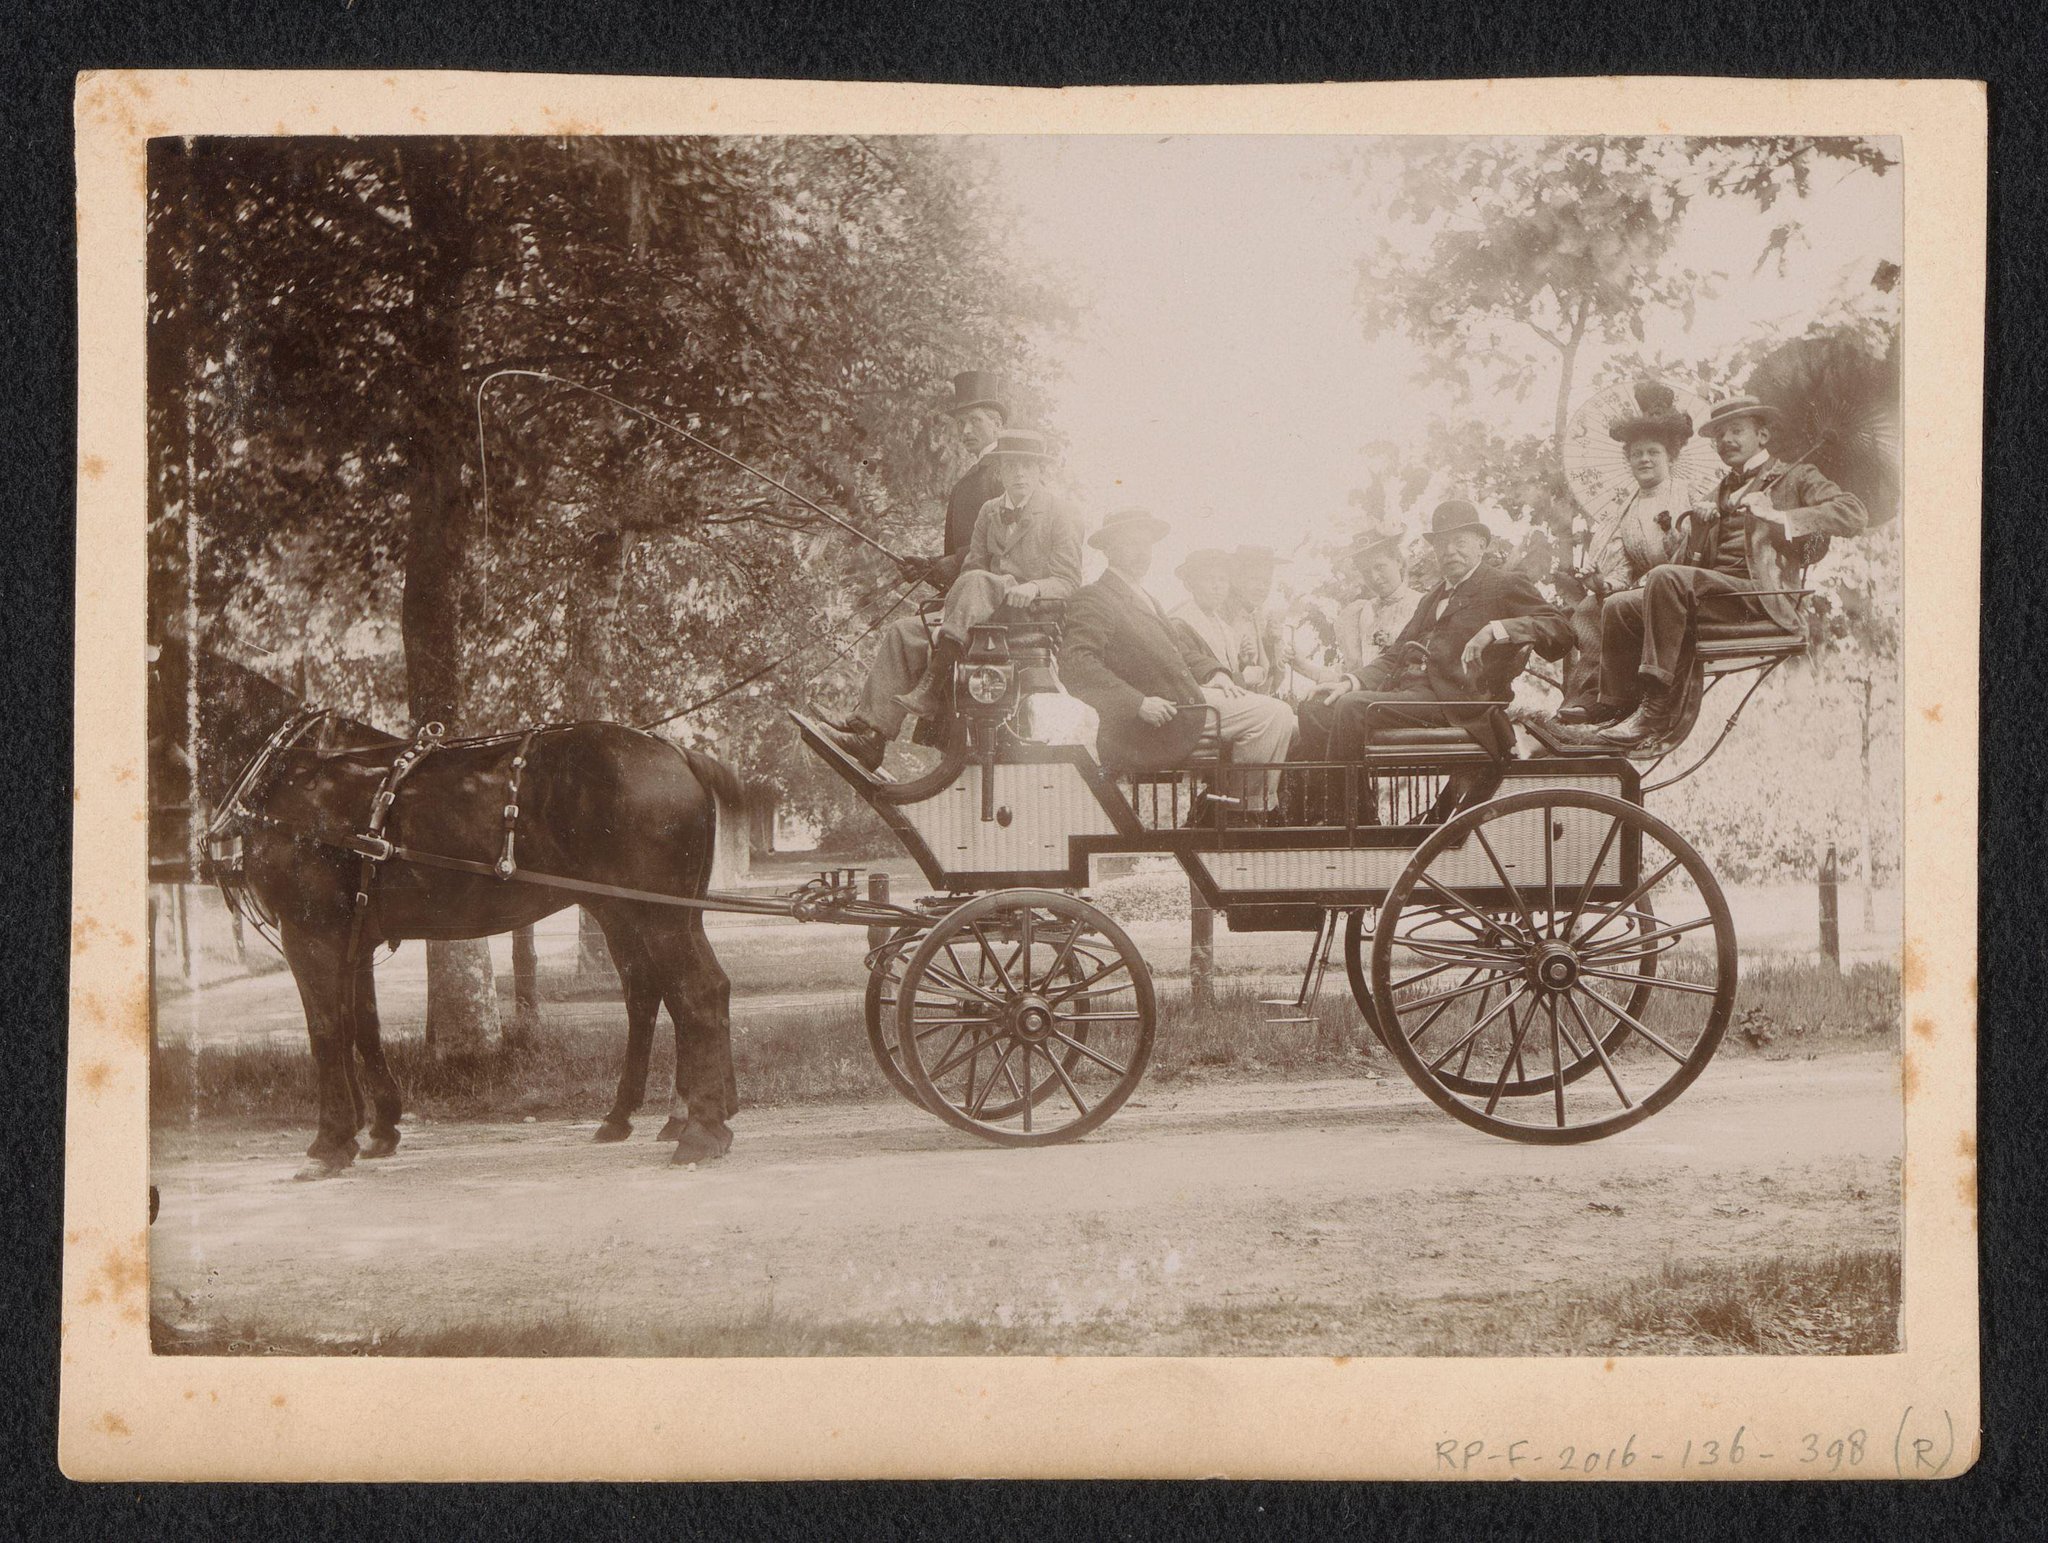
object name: photograph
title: Familie van den Berg op paard en wagen in Baarn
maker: hendrik herman van den berg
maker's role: amateurfotograaf, jurist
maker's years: 1875-1944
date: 1896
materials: cardboard, photographic support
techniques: collodion silver print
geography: baarn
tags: rotterdam, amsterdam, norbertus petrus van den berg (1831-1917), four-wheeled, animal-drawn vehicle, e.g.: cab, carriage, coach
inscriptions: inscription: ‘1896 Baarn op de bok Herman Stelling; vader; oom Wim; tante Jeanne; grootvader N.P.; tante Leo; oom Karel, moeder’